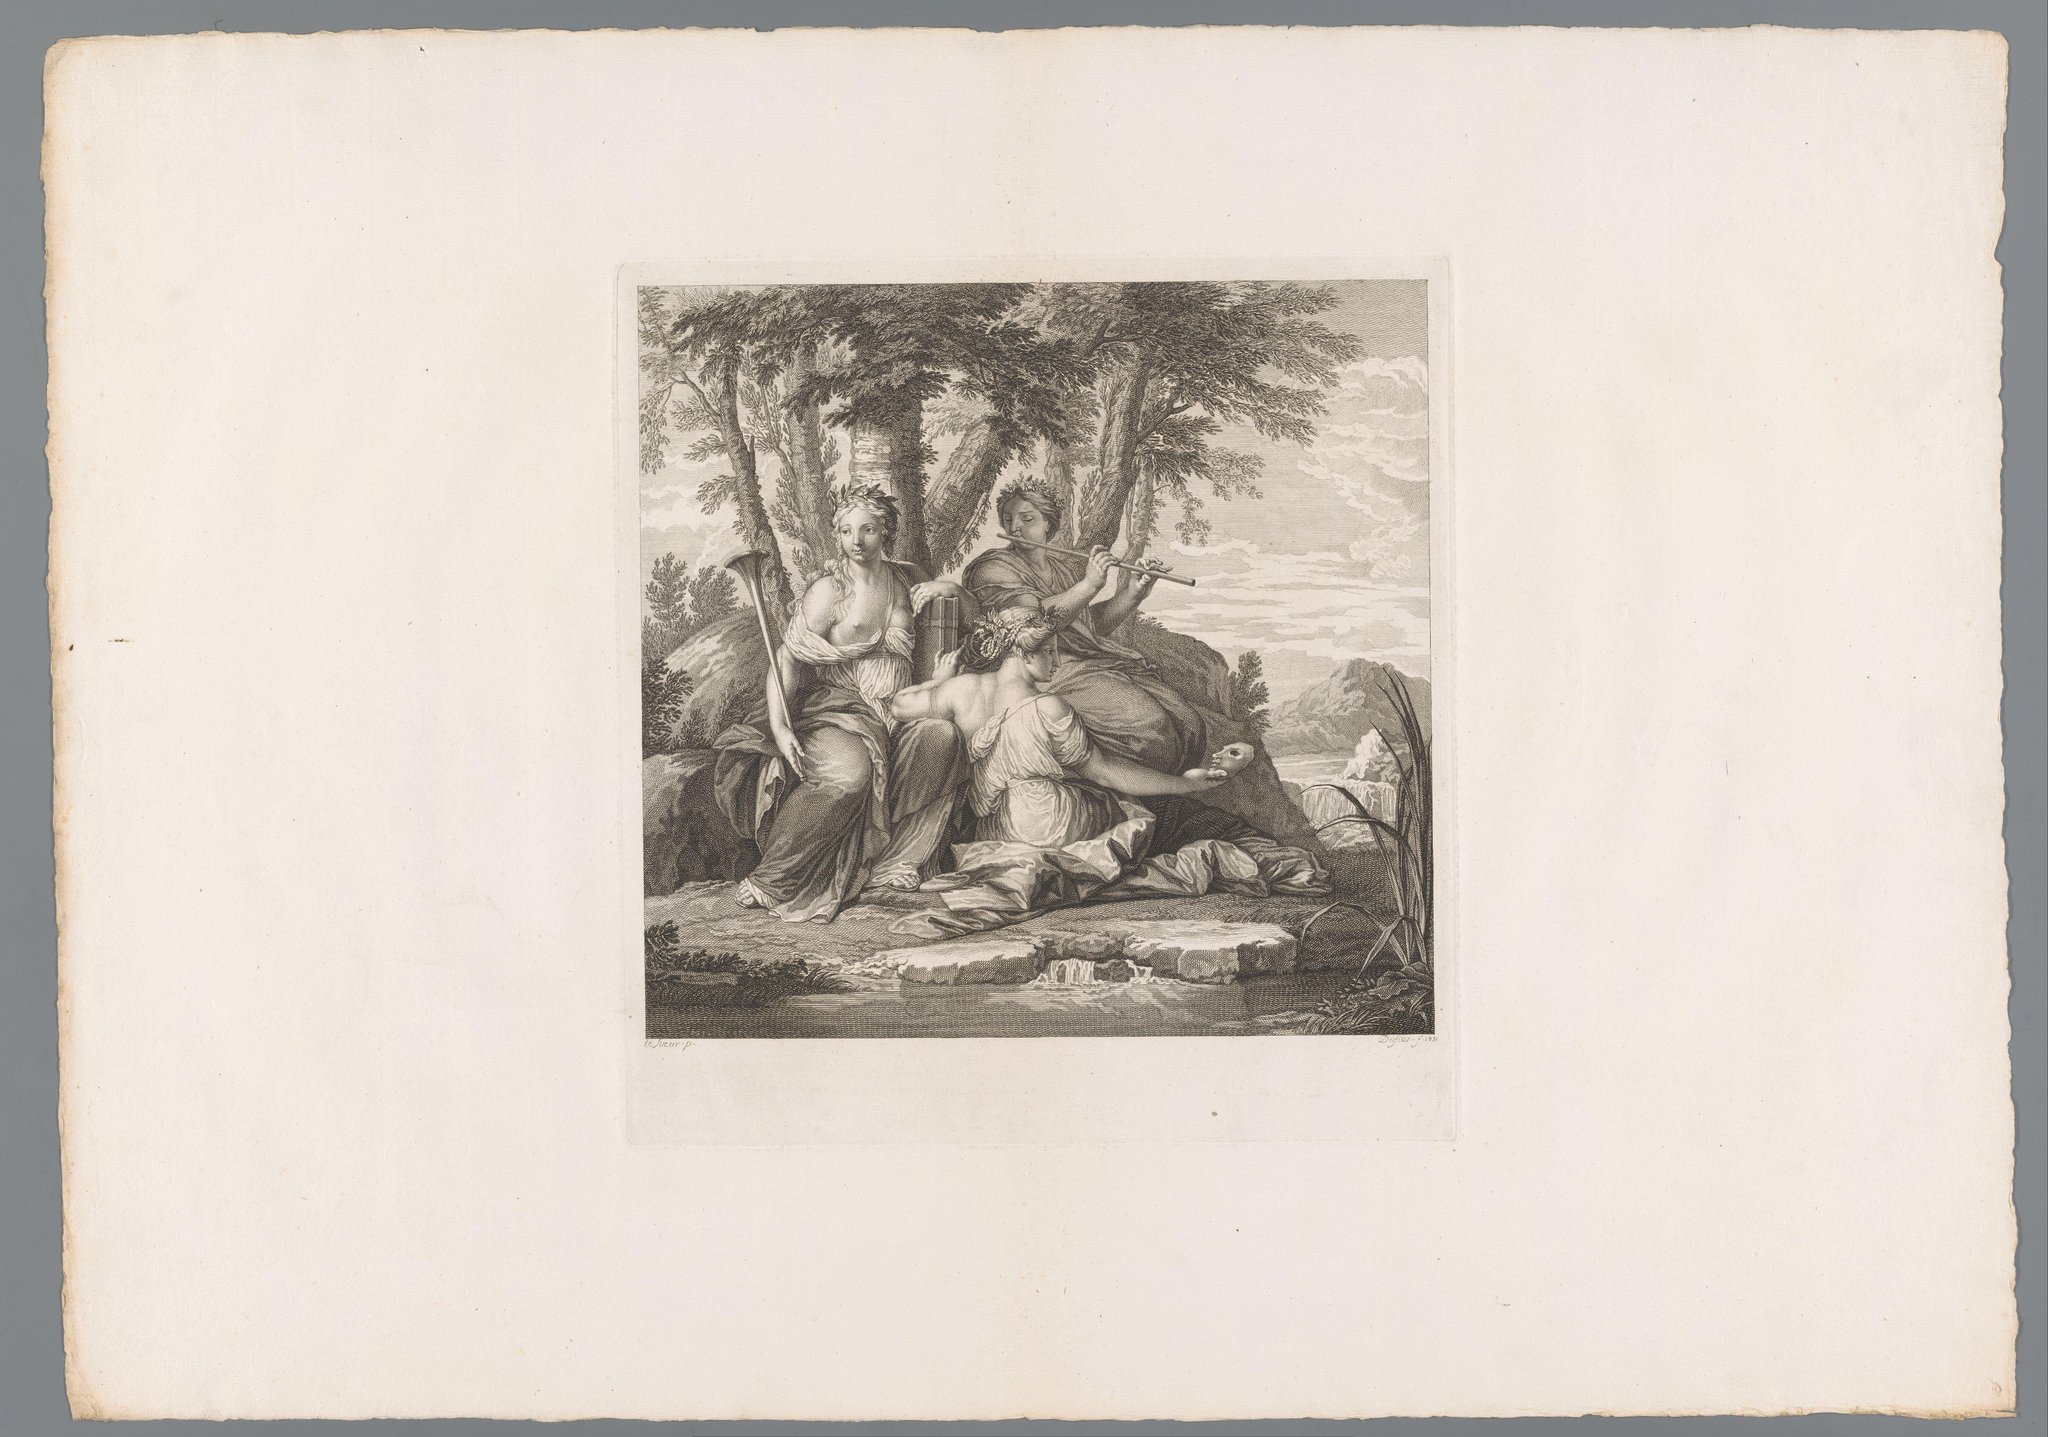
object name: print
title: Les peintures de Charles le Brun et d'Eustache Le Sueur qui sont dans (...) la maison du Président Lambert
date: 1731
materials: paper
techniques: engraving, etching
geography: paris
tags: thalia (one of the muses); 'talia' (ripa), clio (one of the muses); 'clio' (ripa), euterpe (one of the muses); 'euterpe' (ripa)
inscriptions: collector's mark: Lugt 2228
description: Clio, de muze van de geschiedenis met boek en trompet, Euterpe, de muze van muziek en lyriek met een dwarsfluit, en Thalia, de muze van het blijspel en de herderspoëzie met een masker in haar hand, musiceren samen onder een boom. Naar het schilderij in de Chambre des Muses van het Hôtel Lambert. Prent maakt deel uit van een serie prenten naar de schilderijen in het Hôtel Lambert te Parijs.